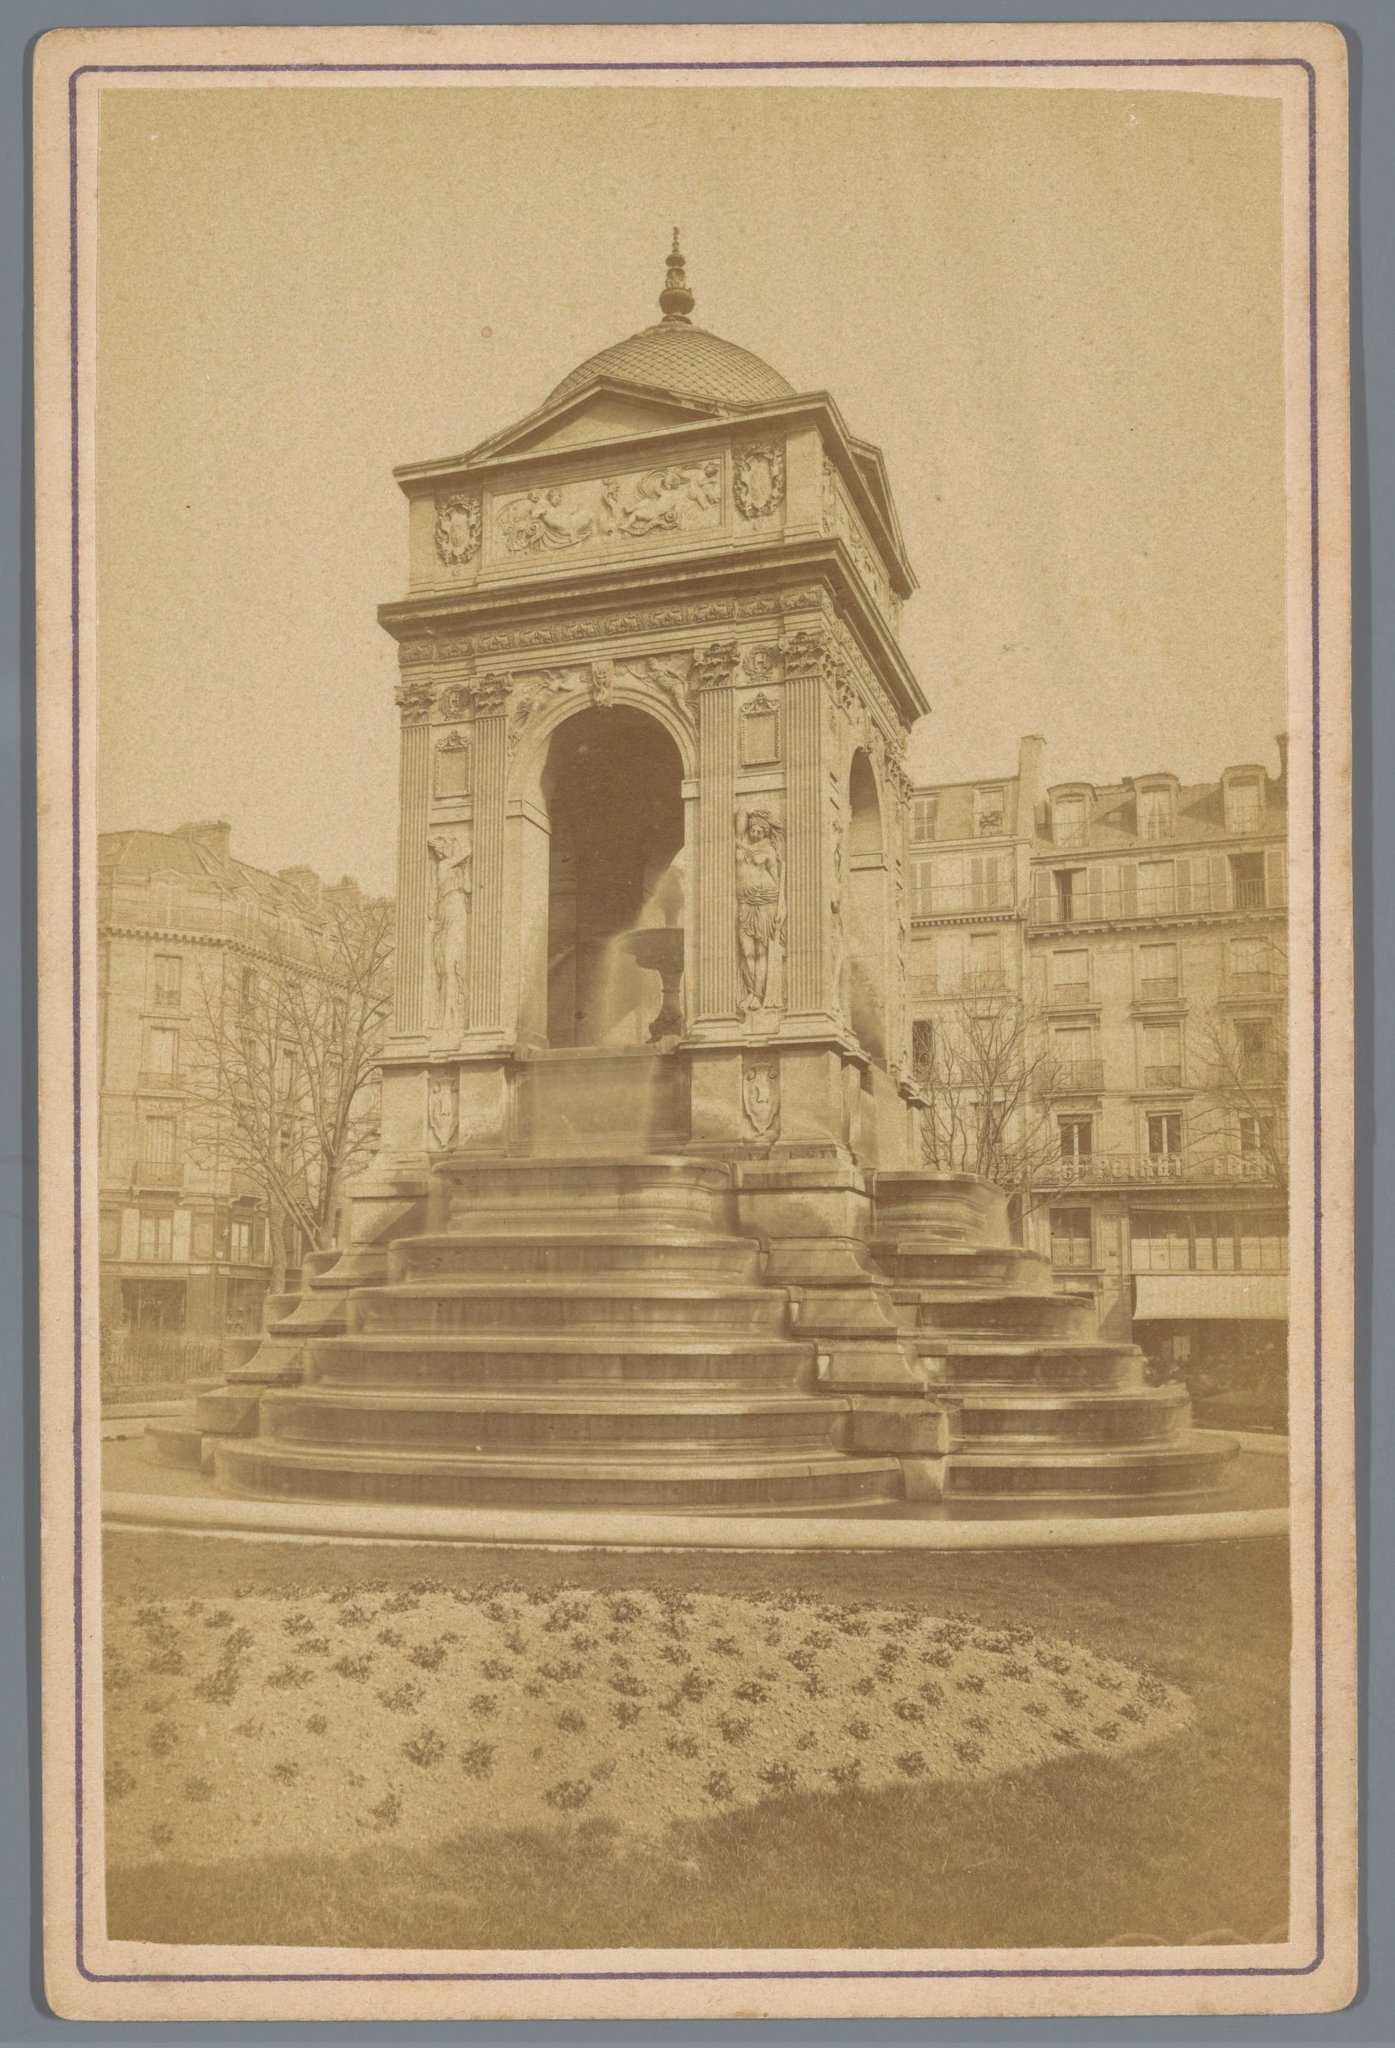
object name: cabinet photograph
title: Fontaine des Innocents te Parijs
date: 1865-1875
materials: cardboard, photographic support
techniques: albumen print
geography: paris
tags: ornamental fountain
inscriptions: inscription: ‘Fontaine des Innocents’, inscription: ‘Compagnie Photographique Debitte & Hervé 170, Rue de Rivoli, Paris’